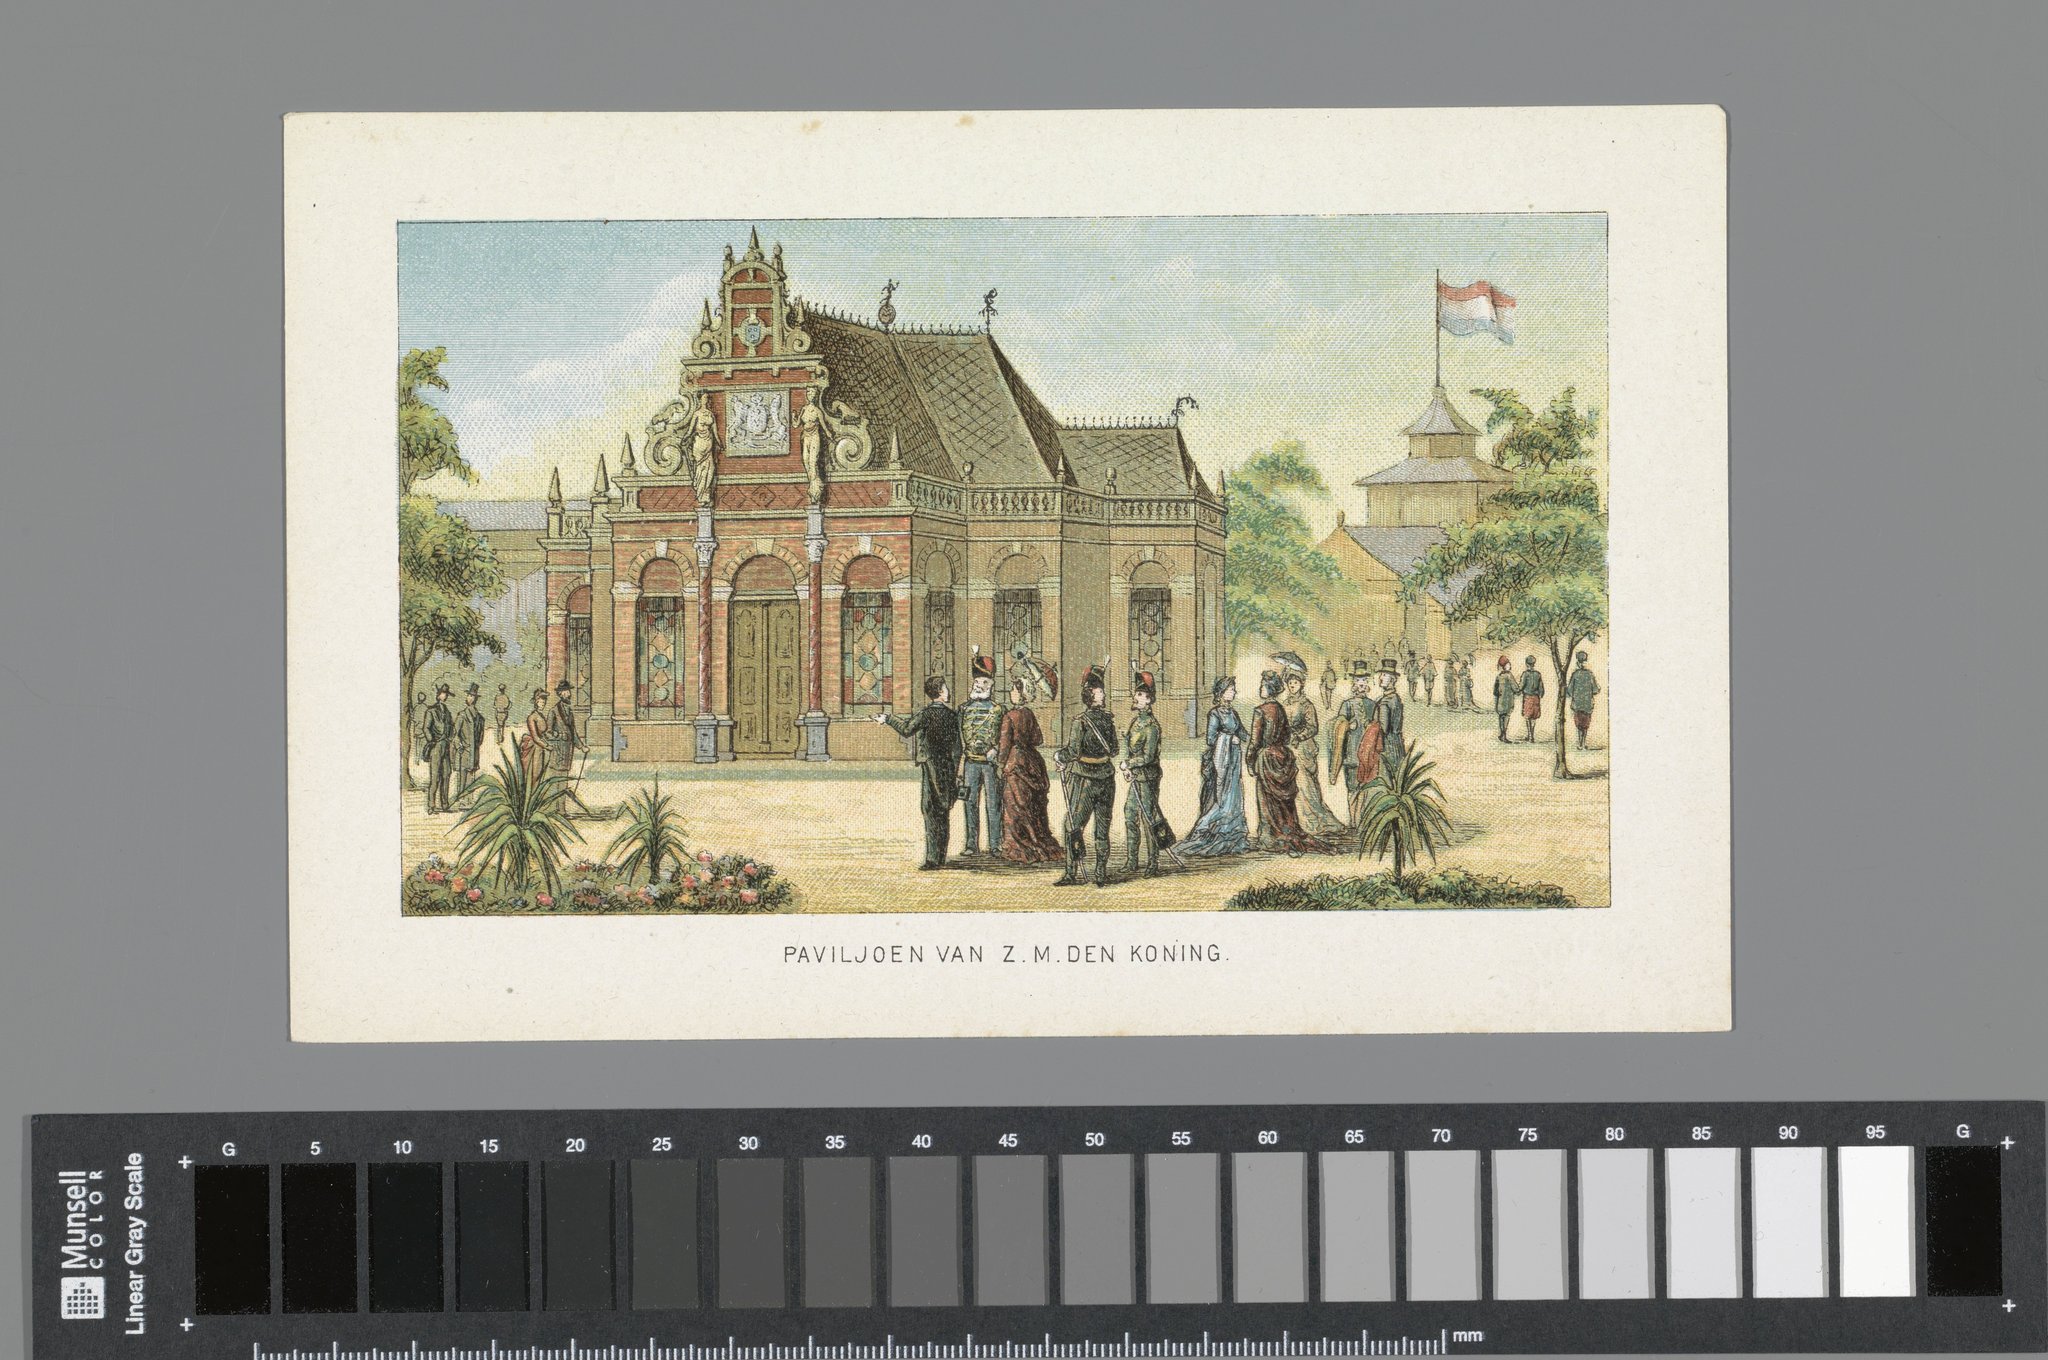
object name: print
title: Paviljoen van de koning op de Wereldtentoonstelling in Amsterdam, 1883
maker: Anonymous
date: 1883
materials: paper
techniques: chromolithography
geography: amsterdam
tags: world fair, world exhibition, amsterdam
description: Paviljoen van de koning op de Wereldtentoonstelling op het Museumplein te Amsterdam. Onderdeel van een groep van zestien platen en een plattegrond van de Wereldtentoonstelling in Amsterdam van 1 mei tot 1 oktober 1883. Uitgave van het Nieuws van den Dag.